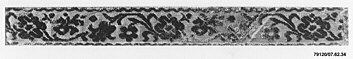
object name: ribbon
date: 1701-1800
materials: silk